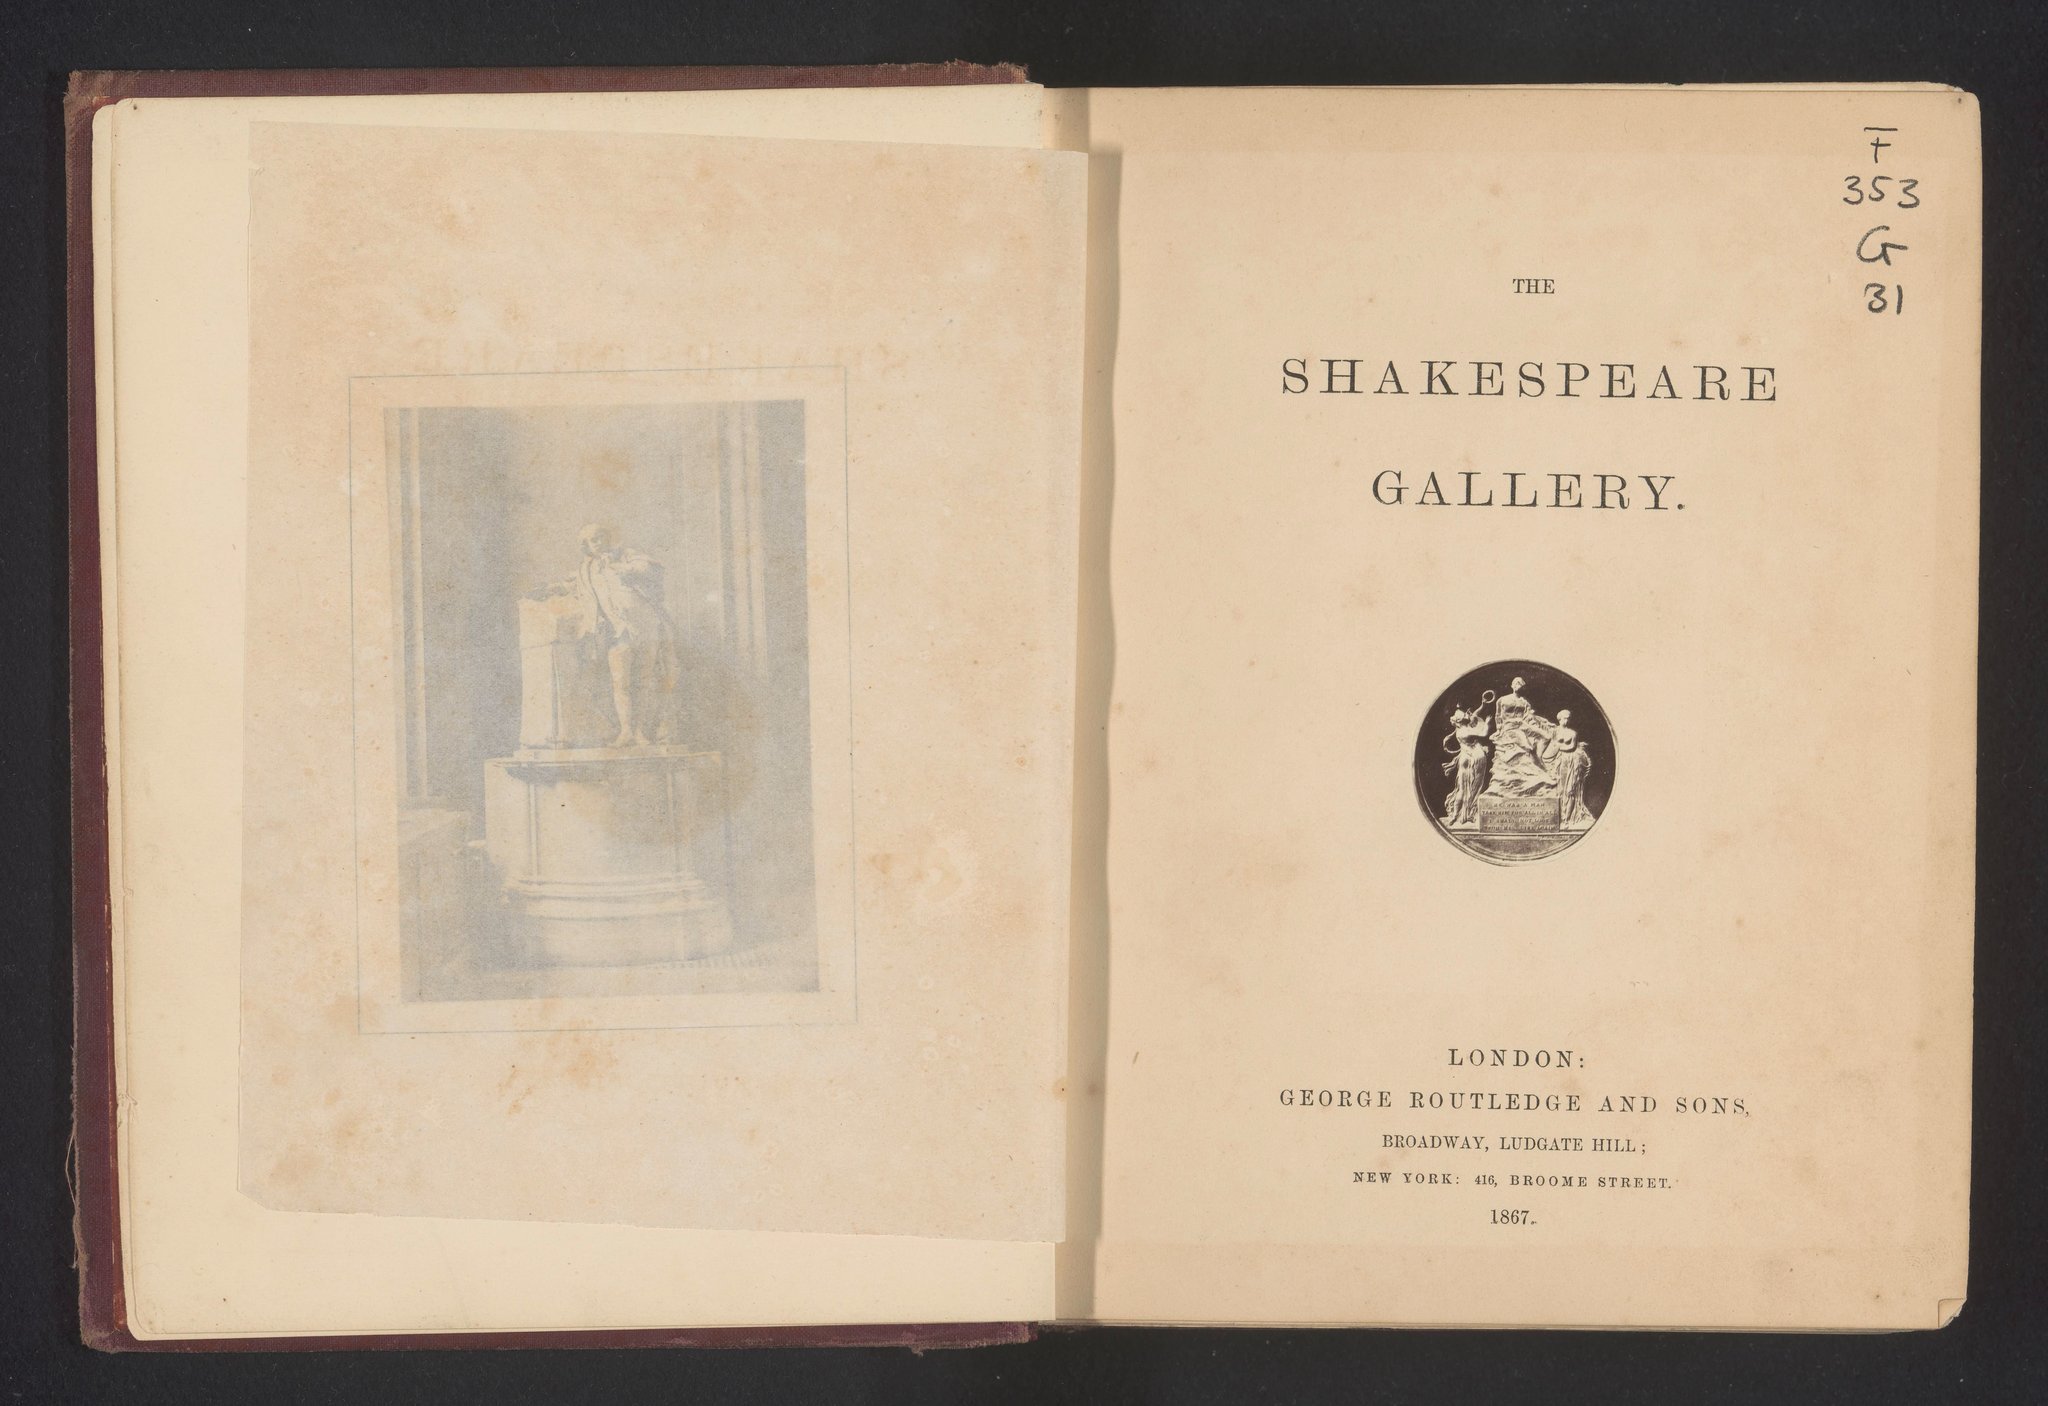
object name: book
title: The Shakespeare gallery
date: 1867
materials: linen, paper, photographic support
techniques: albumen print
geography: london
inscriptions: name: ‘William Henry Fulcher Balmoral Villa Parkstone Road Foole Dorset’